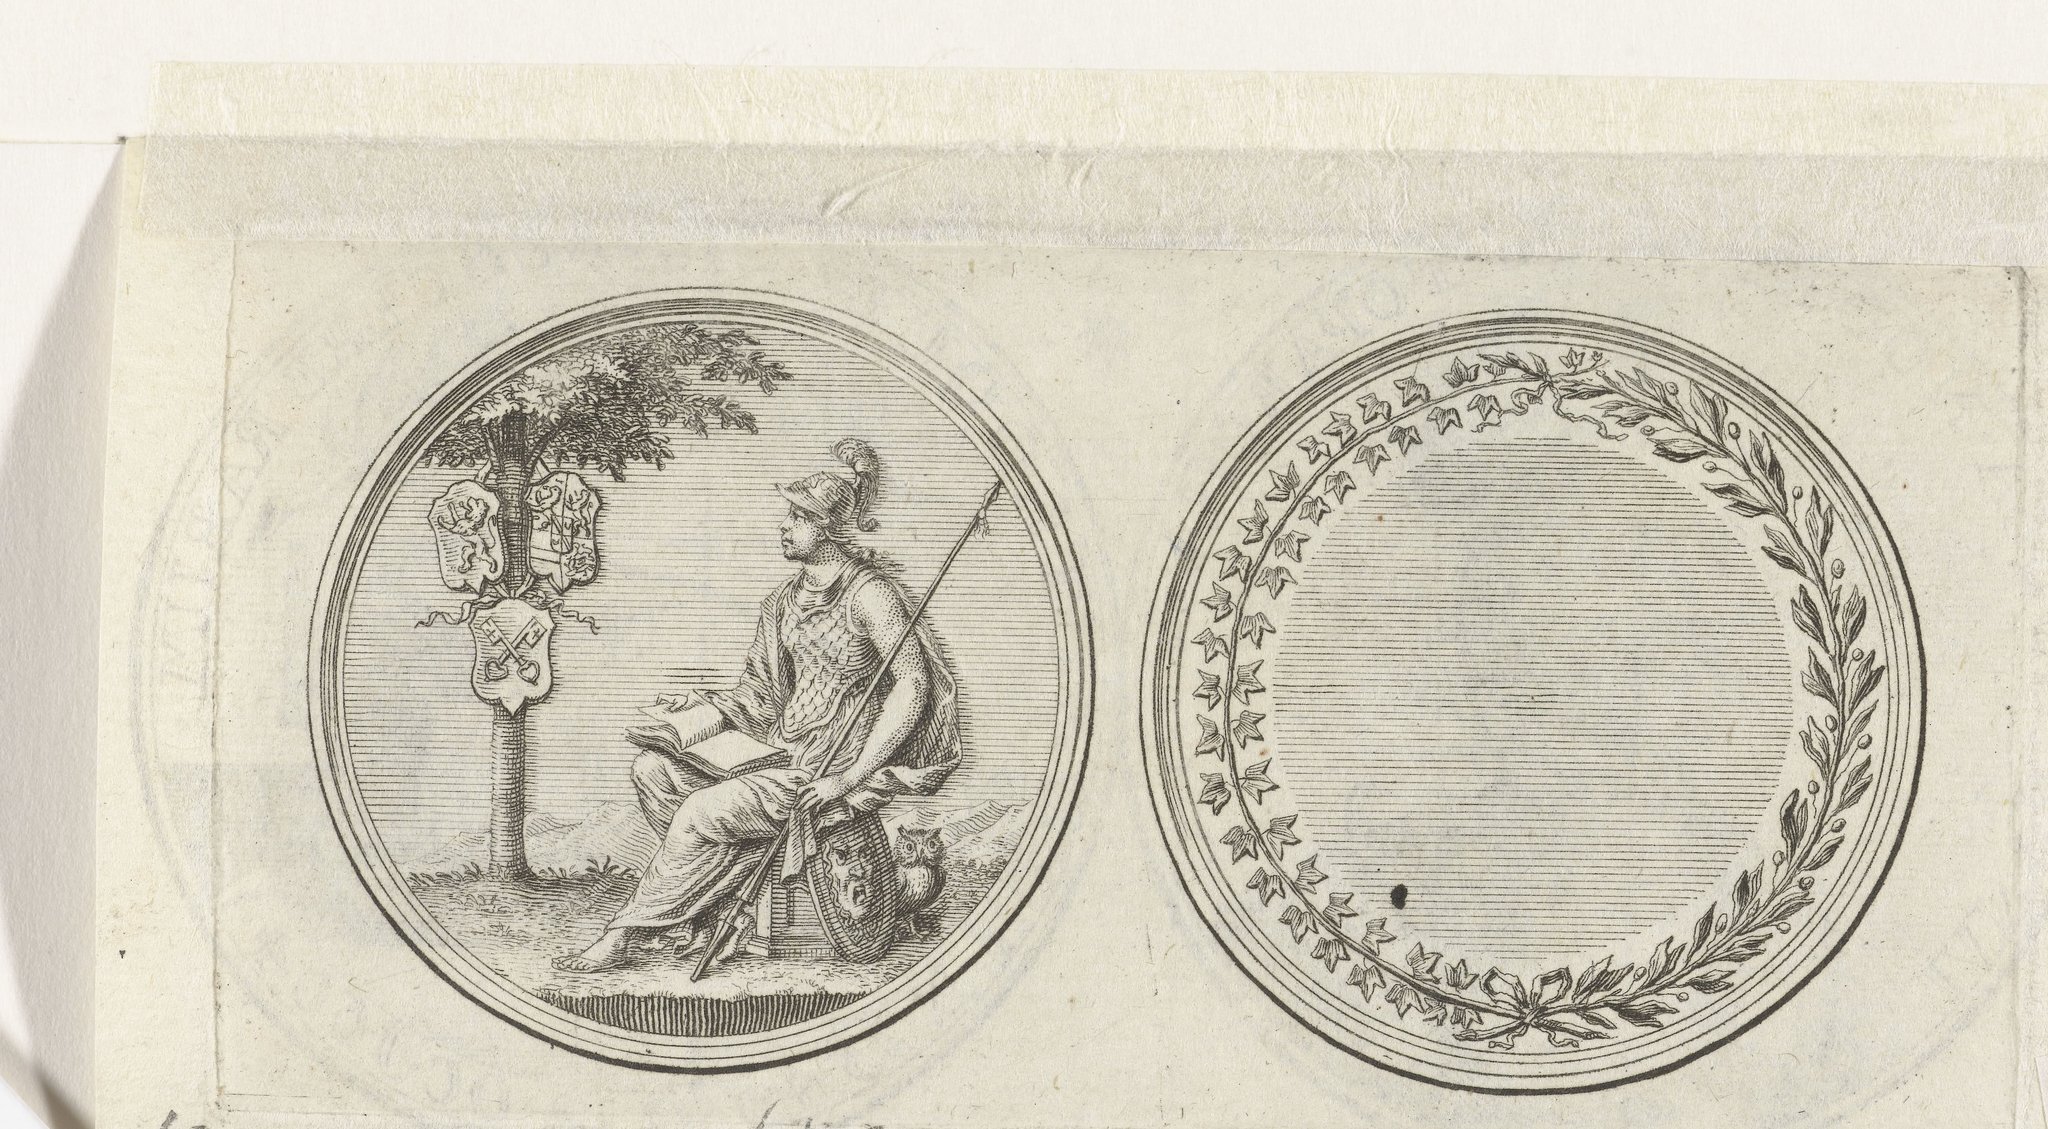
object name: historical object representation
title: Historiepenning met zittende Minerva, 1574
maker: Anonymous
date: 1721-1723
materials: paper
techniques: etching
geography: netherlands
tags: medal (considered as a piece of sculpture, regardless of its specific function), leiden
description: Penning van de Staten van Holland als beloning voor verdienste aan de Universiteit van Leiden. Op de voorzijde zittende Minerva bij boom met wapens van Holland, prins van Oranje en Leiden. Keerzijde is blanco en bestemd voor opschrift. Historiepenning van 1574.